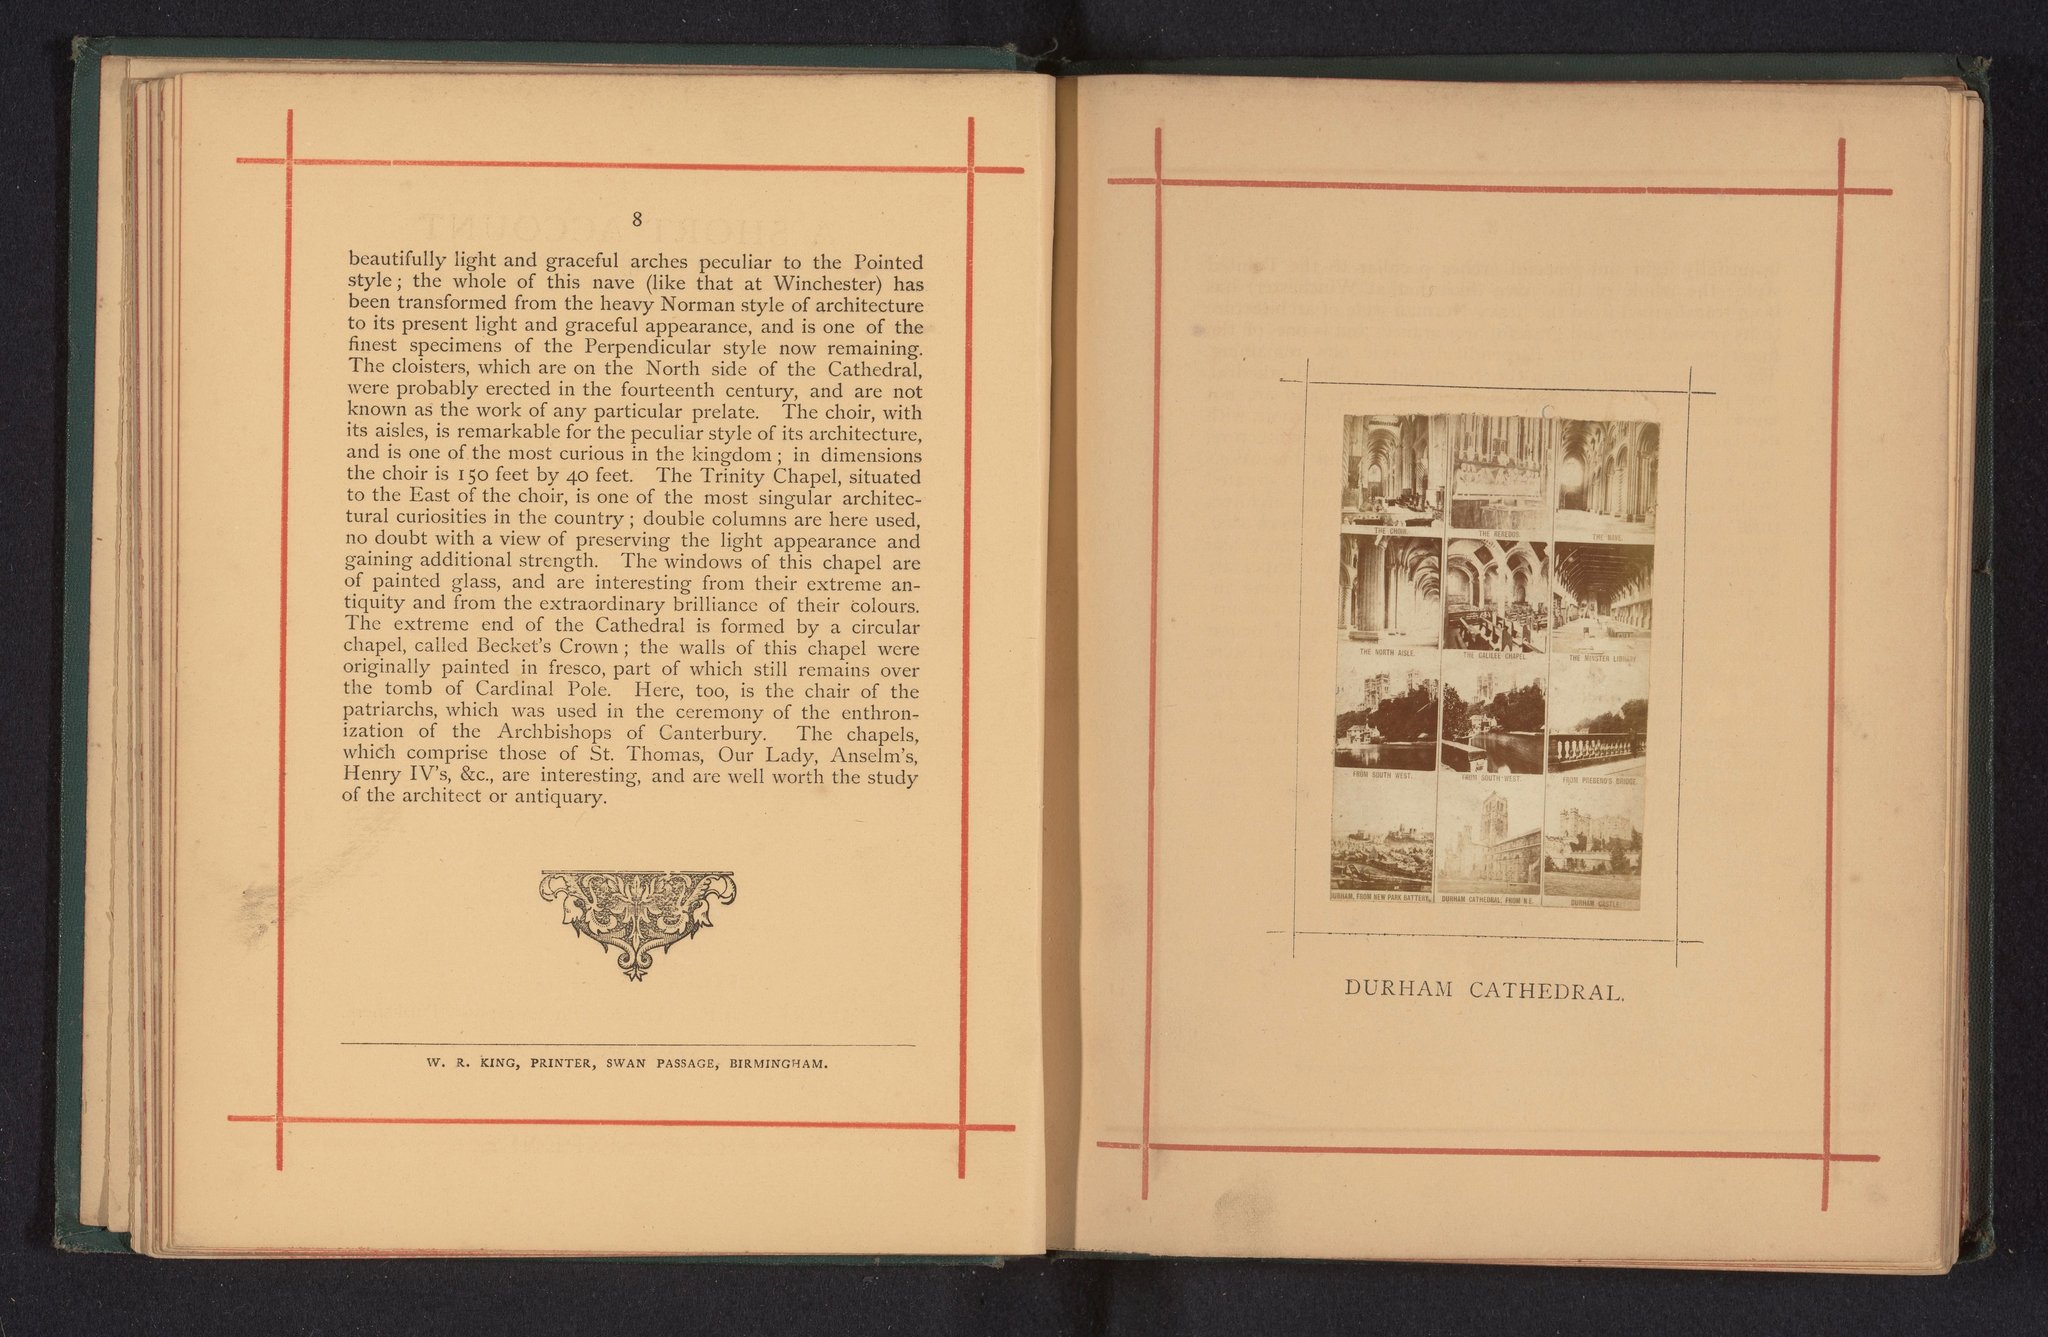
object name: photograph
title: Fotoreproductie van twaalf foto's van de kathedraal van Durham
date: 1870-1880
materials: photographic support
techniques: albumen print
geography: durham cathedral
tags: church (exterior), parts of church interior: nave, parts of church interior: choir, parts of church interior: chapel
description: Van boven naar beneden en van links naar rechts: het koor, het altaarstuk, het schip, een zijbeuk, een kapel, de bibliotheek, viermaal een gezicht op de kathedraal, tweemaal de façade.